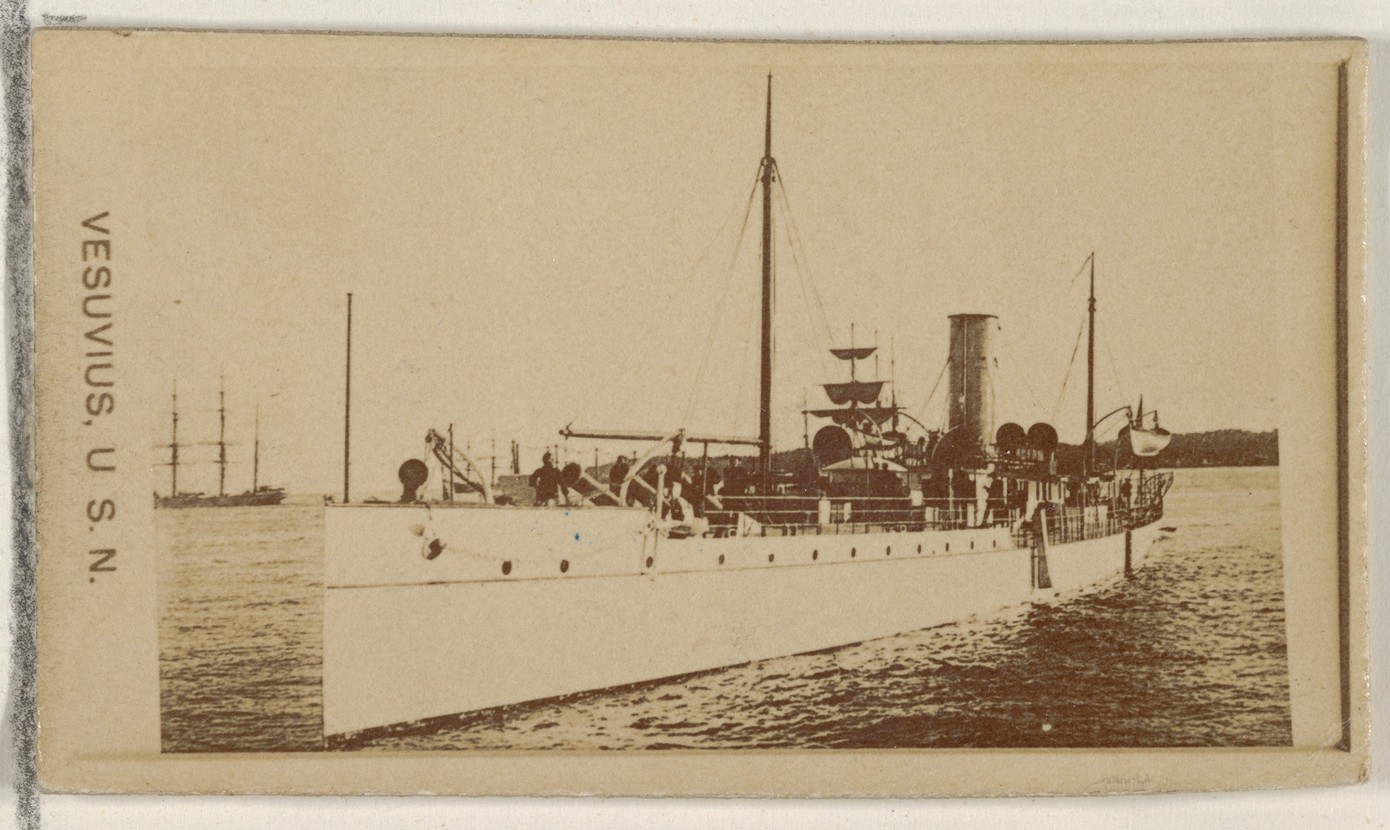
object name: photograph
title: Vesuvius, U.S.N., from the Famous Ships series (N50) for Virginia Brights Cigarettes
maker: allen & ginter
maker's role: publisher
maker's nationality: american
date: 1895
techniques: albumen silver print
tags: ships